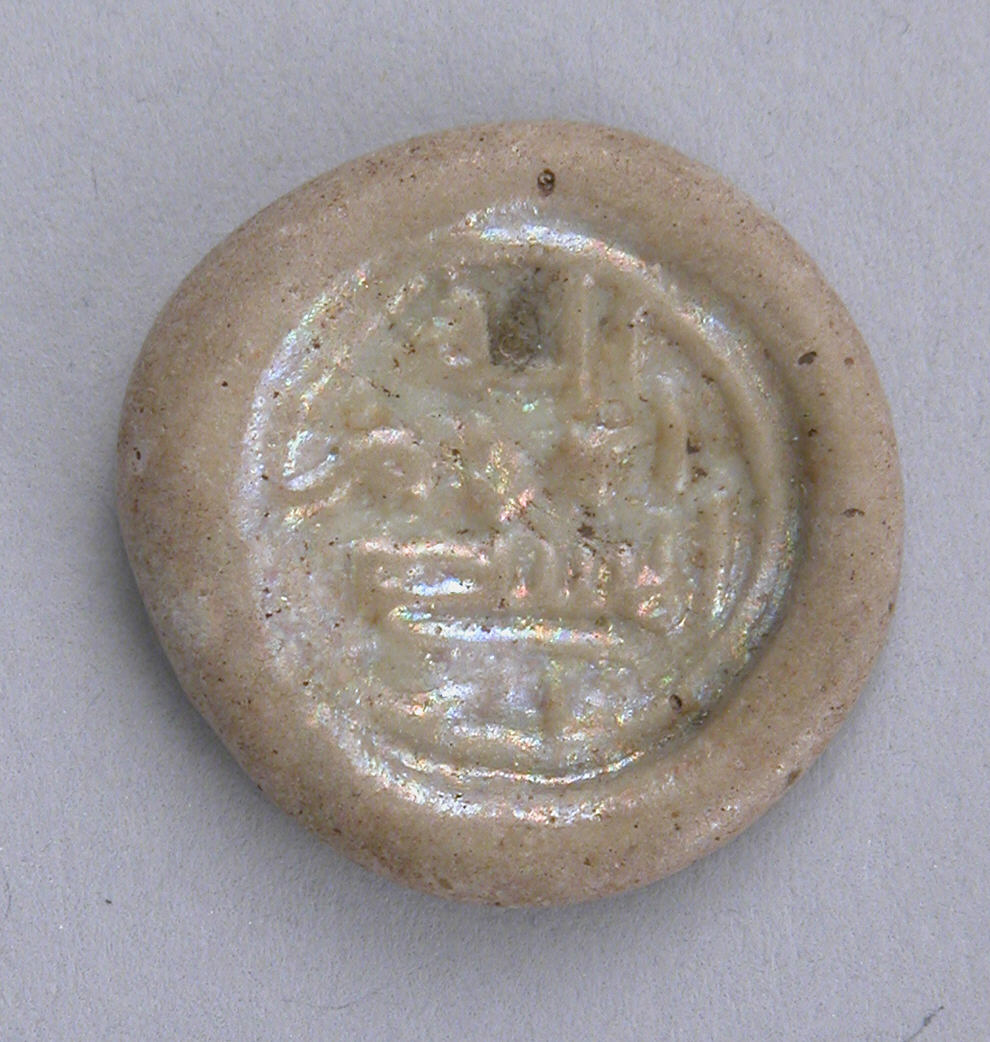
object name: coin weight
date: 1101-1200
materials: glass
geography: egypt